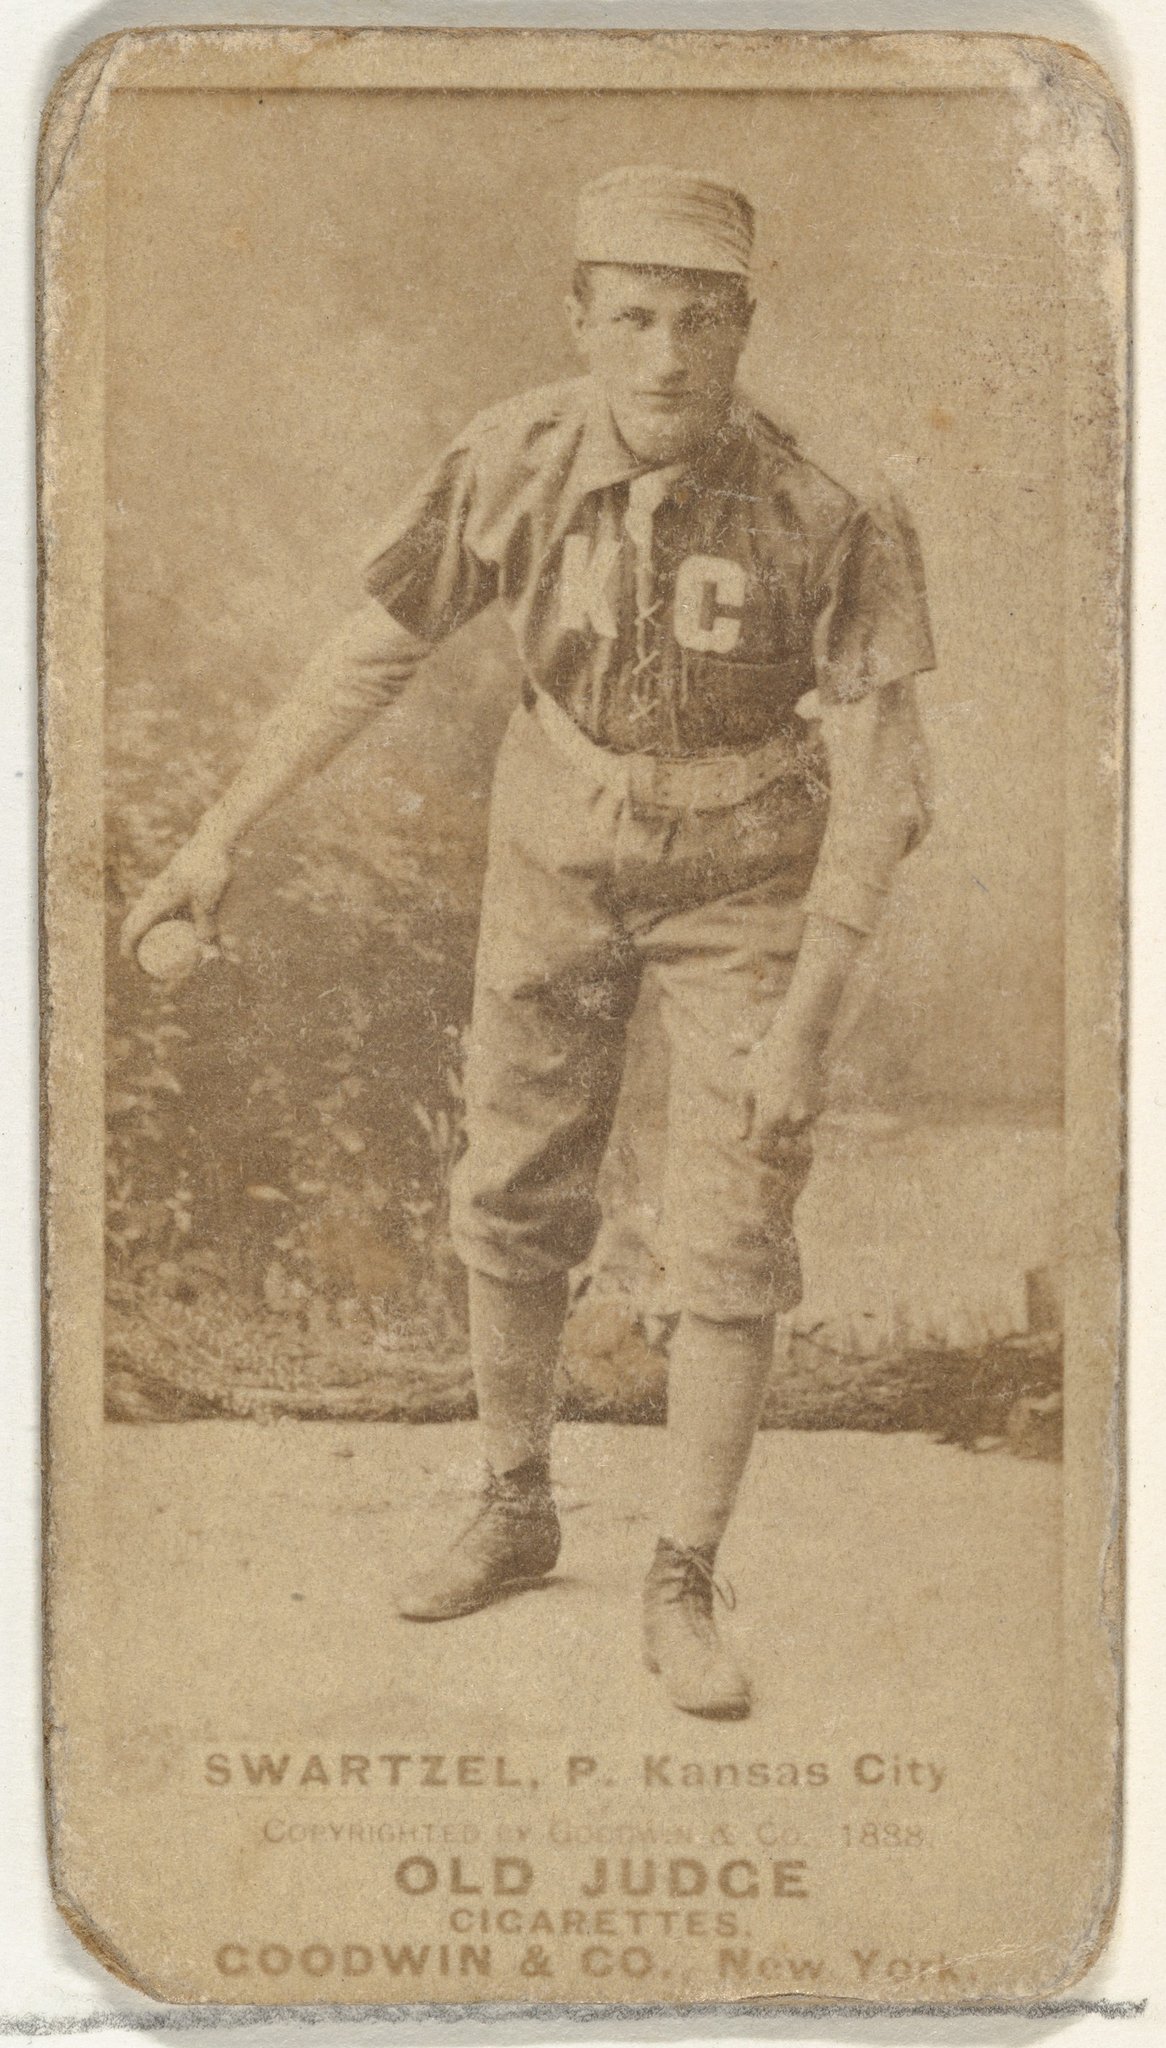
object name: baseball card, photograph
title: Parke B. Swartzel, Pitcher, Kansas City Cowboys, from the Old Judge series (N172) for Old Judge Cigarettes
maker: goodwin & company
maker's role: publisher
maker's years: 1850-1950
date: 1888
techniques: albumen silver print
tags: men,portraits,baseball,athletes